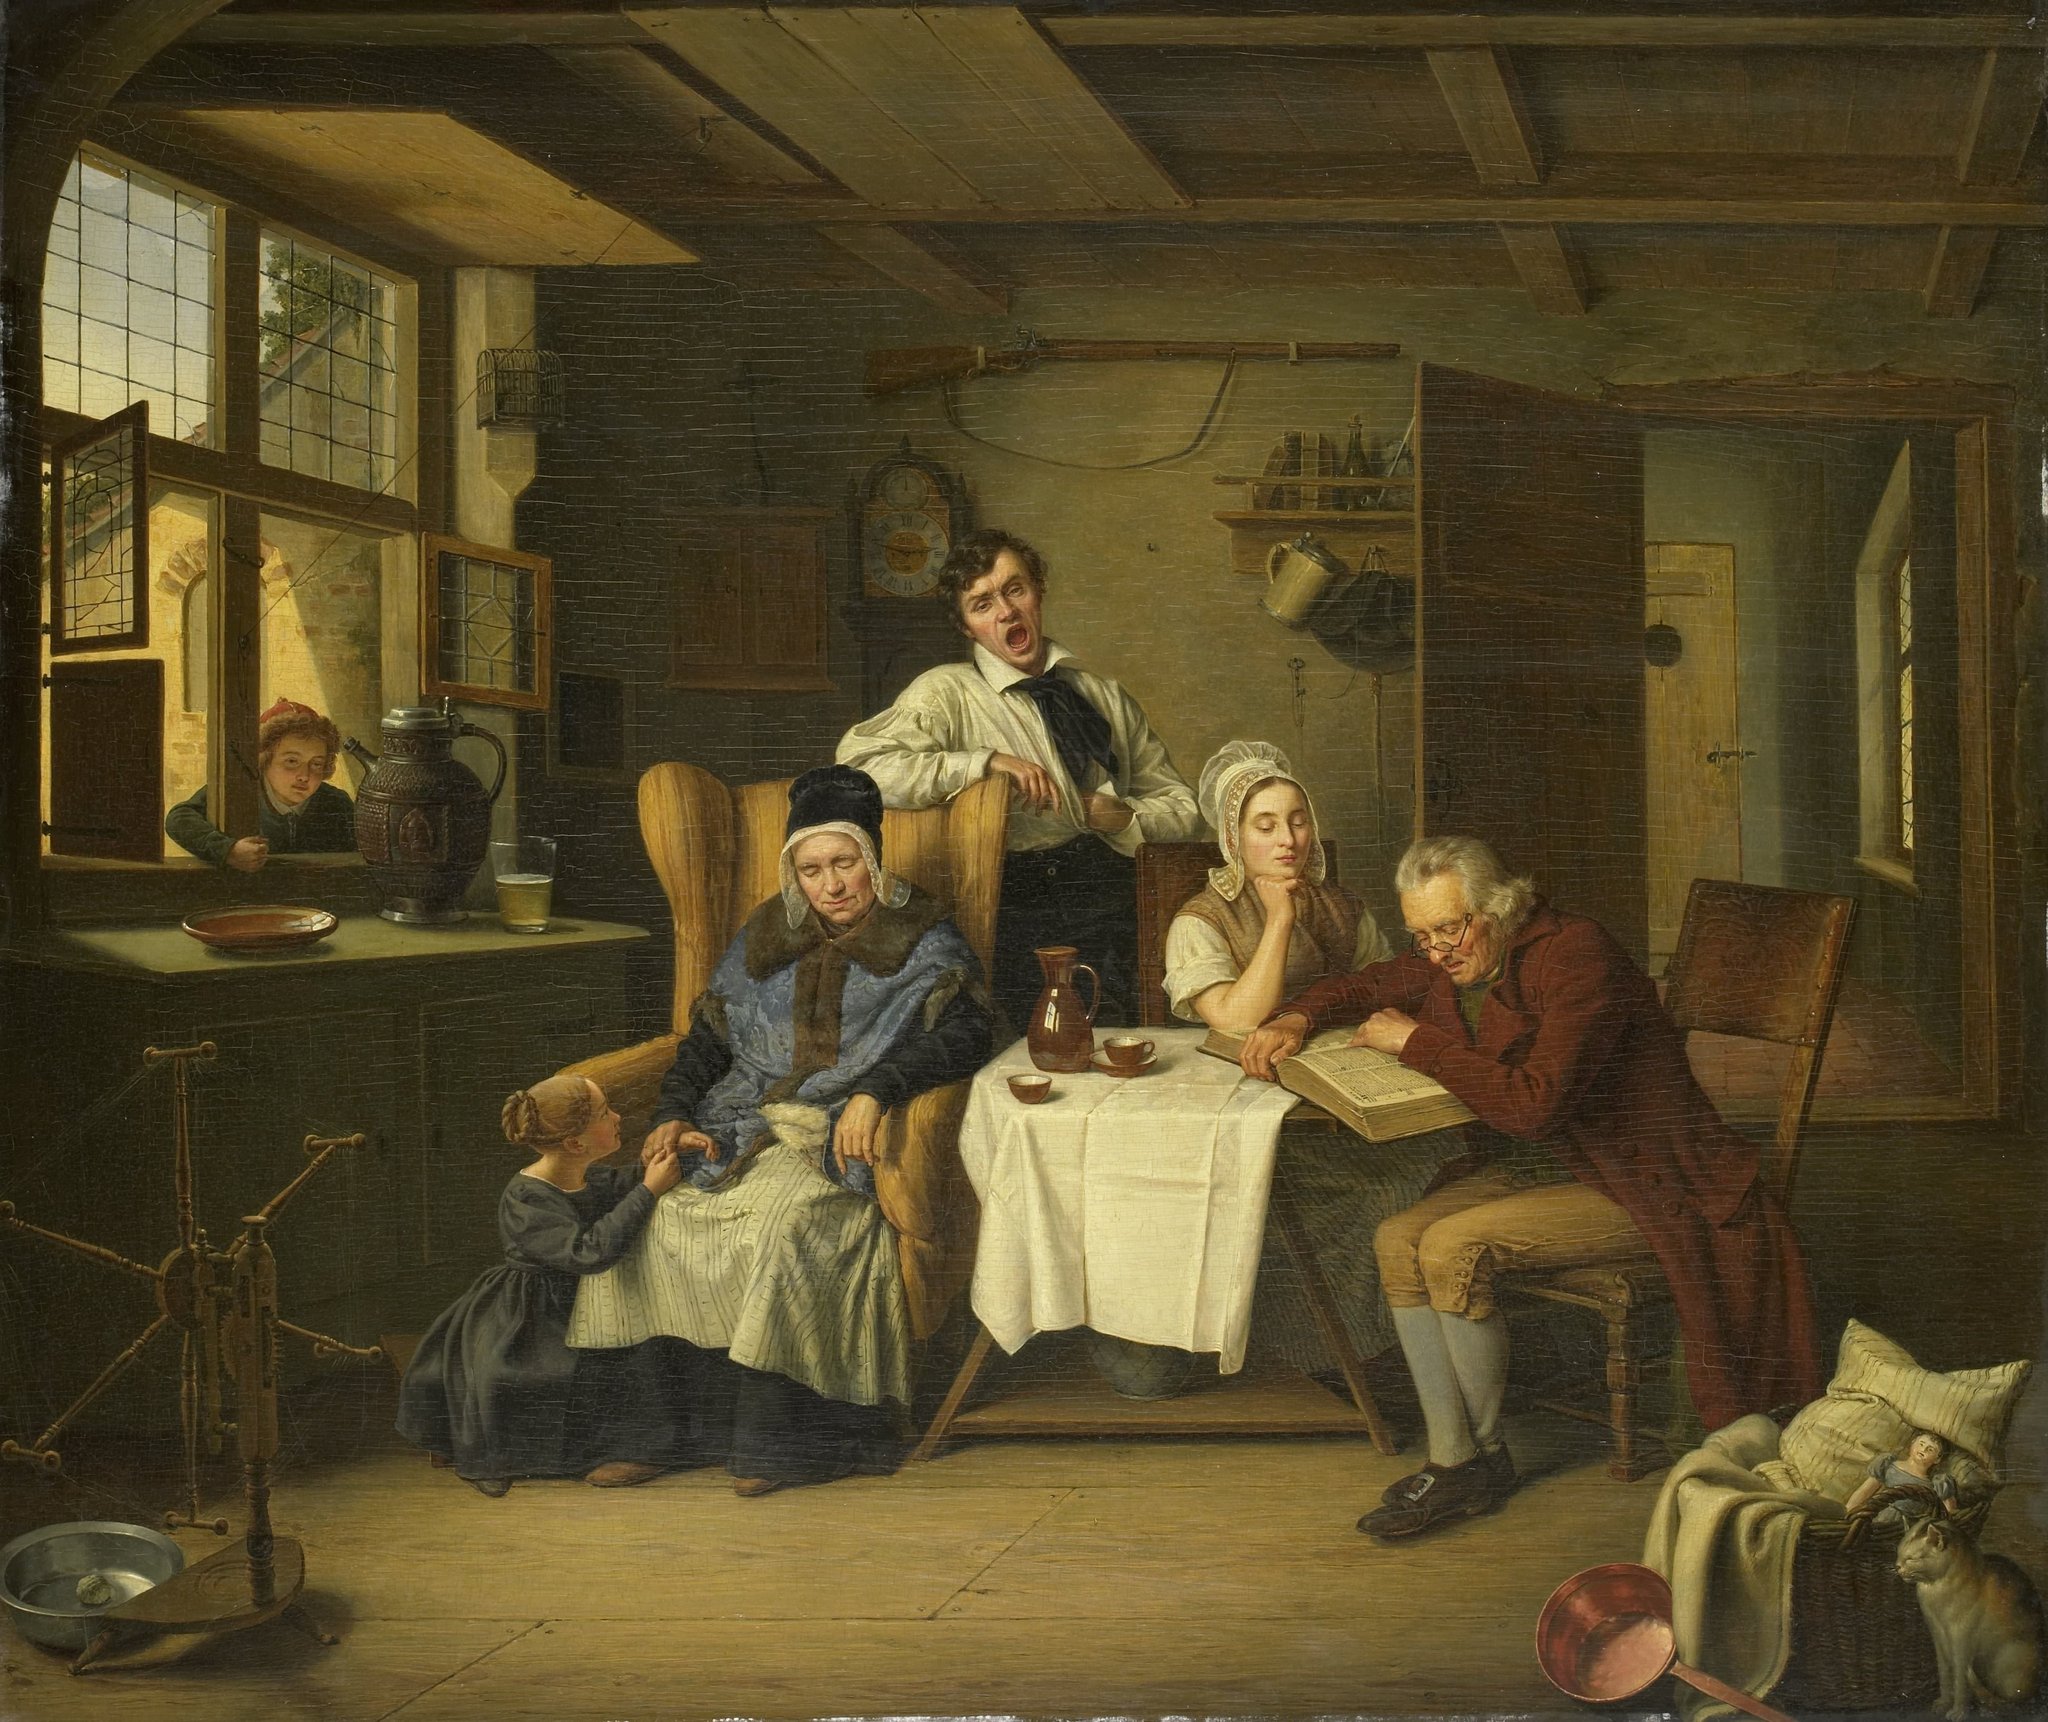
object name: painting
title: Bible Reading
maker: eduard karl gustav lebrecht pistorius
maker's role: painter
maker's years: 1796-1862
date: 1831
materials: canvas, oil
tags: family life at home, reading to somebody, living-room, parlour, sitting-room, the bible as a book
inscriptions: signature and date: ‘Pistorius p. 1831’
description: Bijbellezen. Interieur waarin de vader voorleest uit een bijbel. Aan tafel zit een oude vrouw met gesloten ogen, bij haar voeten knielt een jong meisje. Naast de vader luistert een jonge vrouw, links van haar staat een jonge man te gapen. Een jongen kijkt door het venster links naar binnen. Links een spinnewiel, rechts een kat bij een wasmand. Aan de wand hangen een klok en een geweer.